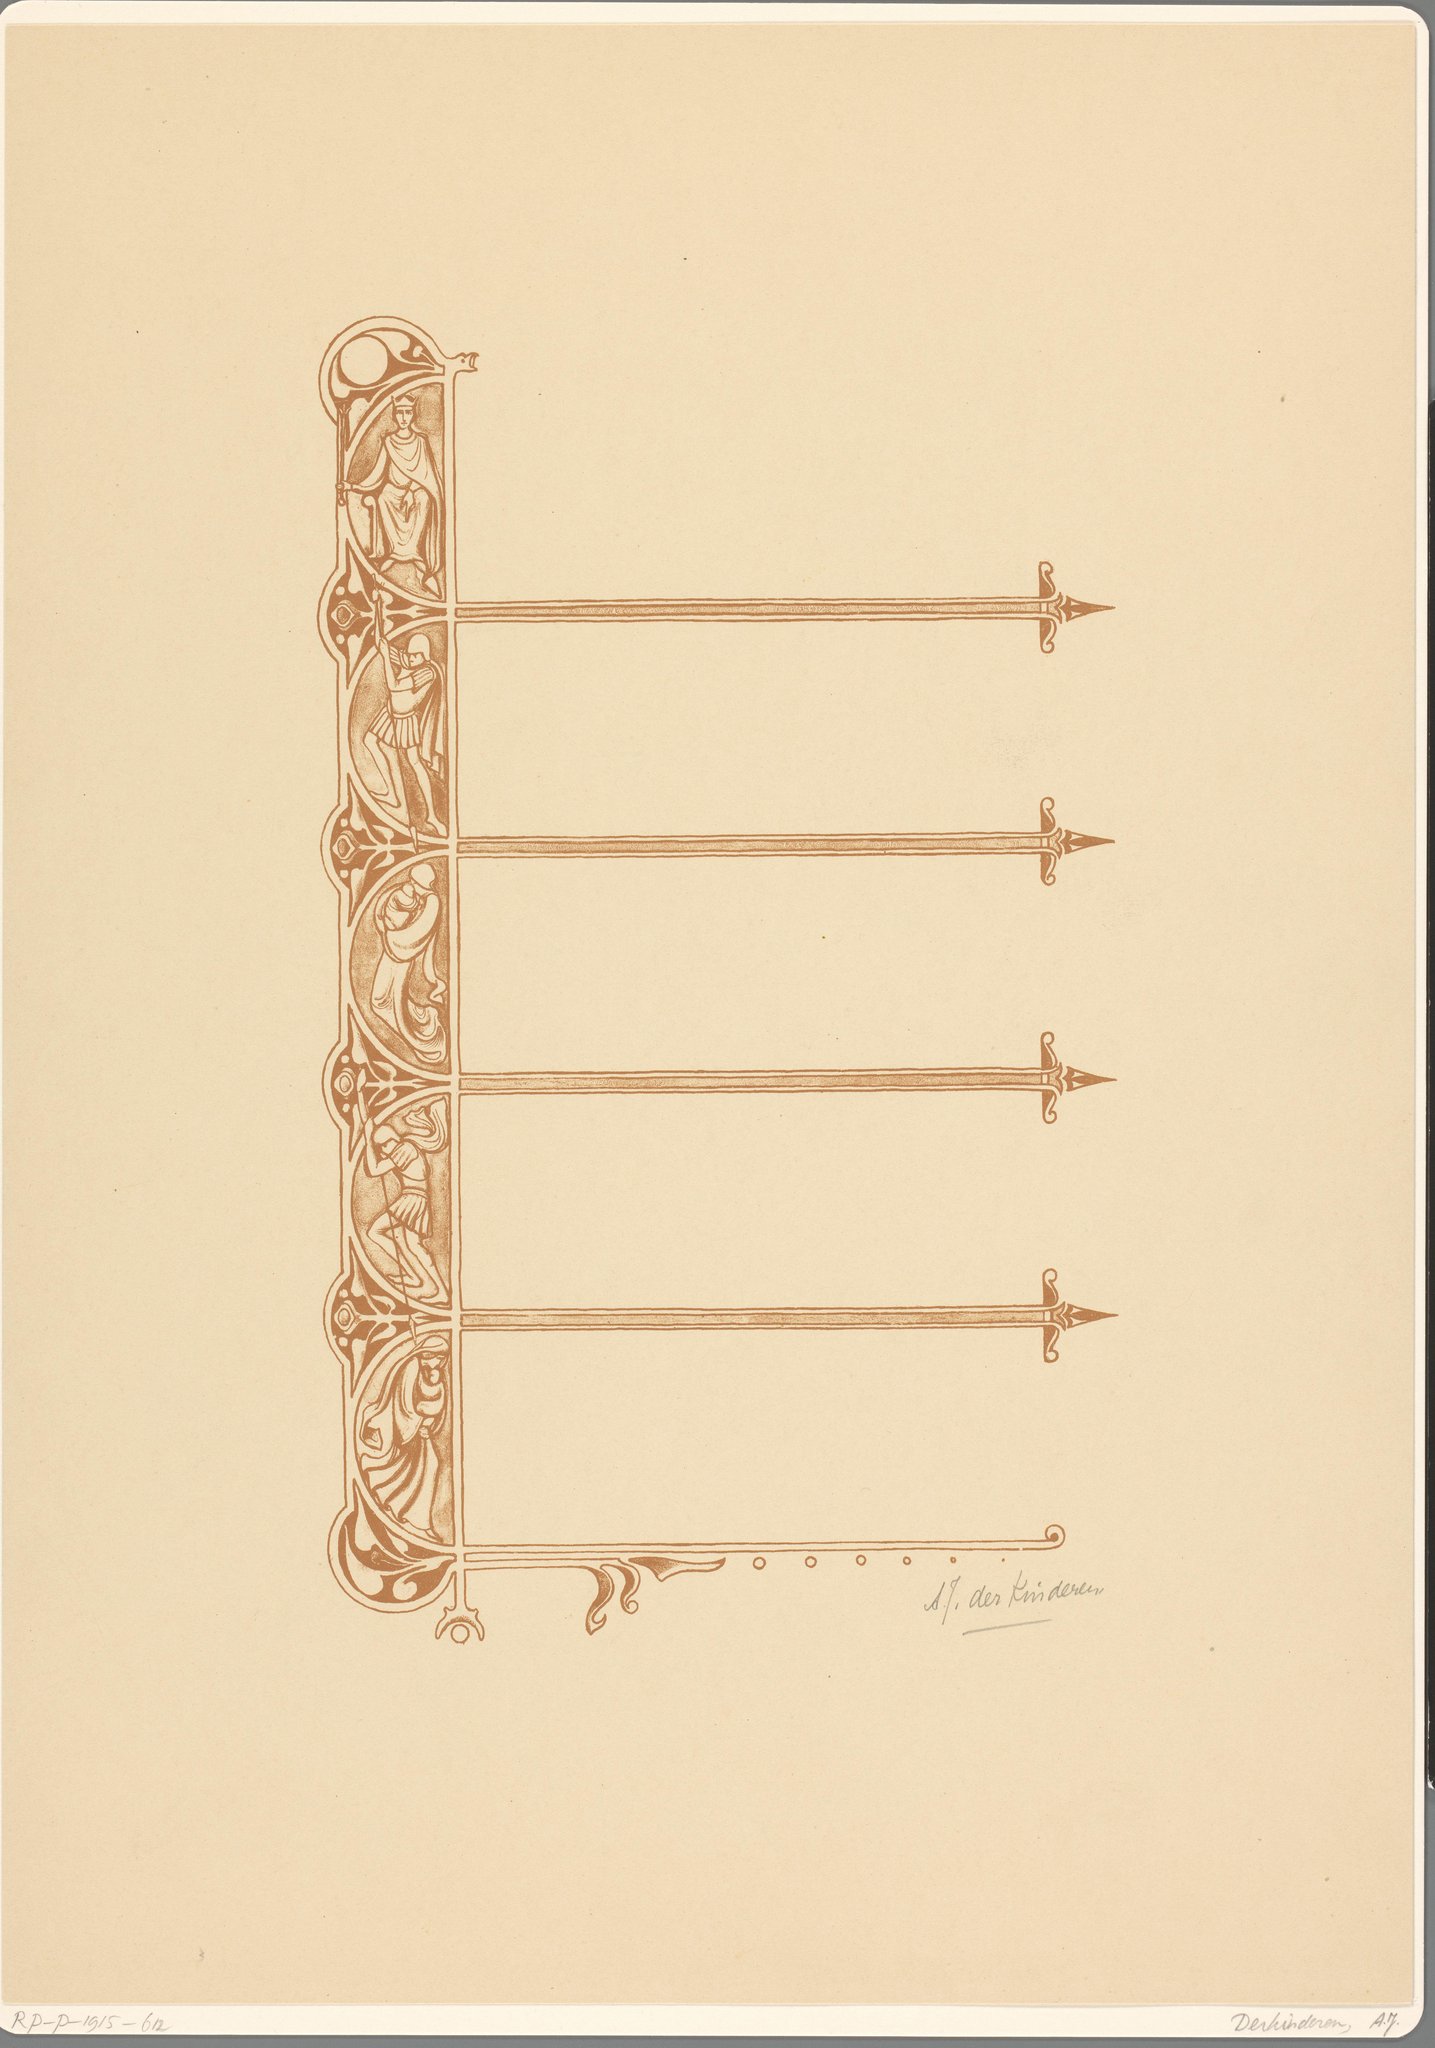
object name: book illustration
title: Koning, ridders, vrouwen met kind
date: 1894-1901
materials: paper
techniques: lithograph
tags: mother and baby or young child, king, knight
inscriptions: collector's mark: Lugt 2233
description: Vijf horizontale, decoratieve banden met daarboven en daartussenin ruimte voor tekst. Links van de banden een verticale sierrand met daarin de beeltenissen van een koning, twee ridders en twee vrouwen met kind.